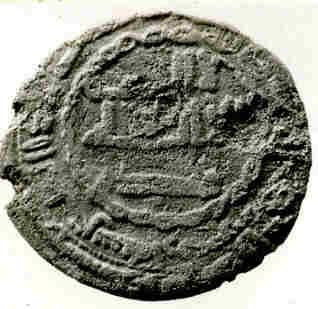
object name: coin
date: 144-761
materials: copper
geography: iran